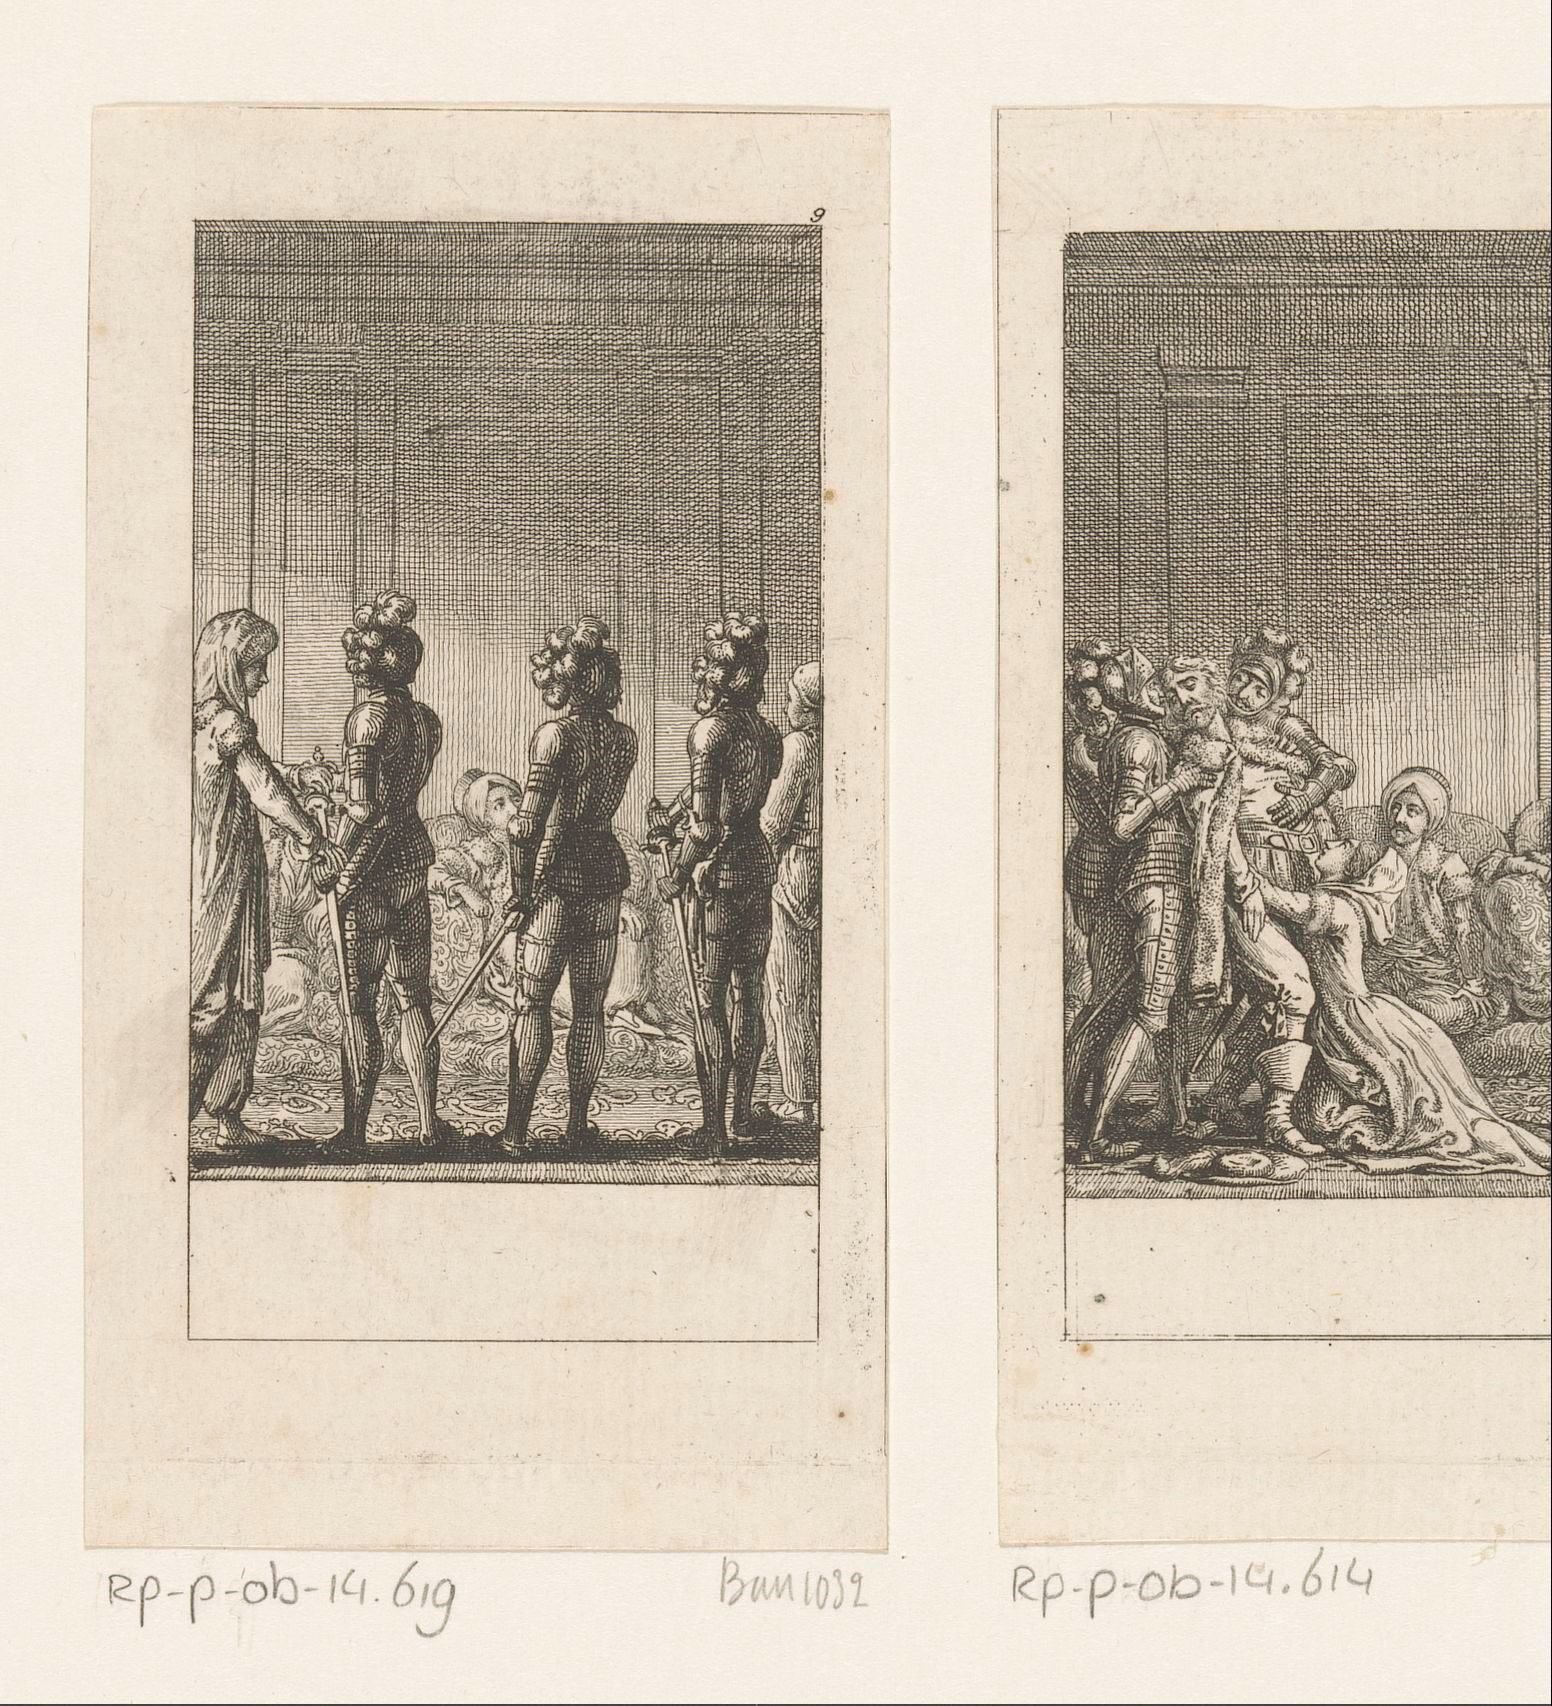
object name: print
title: Bassa spreekt zijn vonnis uit na de mislukte vluchtpoging van Adelheid en Karl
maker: daniel nikolaus chodowiecki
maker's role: draughtsman, print maker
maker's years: 1726-1801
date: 1783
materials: paper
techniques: etching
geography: berlin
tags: literature, hacking and thrusting weapons: sword, head-gear: turban, interior of the house, the soldier; the soldier's life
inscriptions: collector's mark: Lugt 2228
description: Vervaardigd voor G. F. W. Grossmann's 'Adelheid von Veltheim'. Een latere staat gebruikt in: Königlich Grosbritannischer genealogischer Kalender auf das Jahr 1784. Lauenburg: Berenberg, 1783.